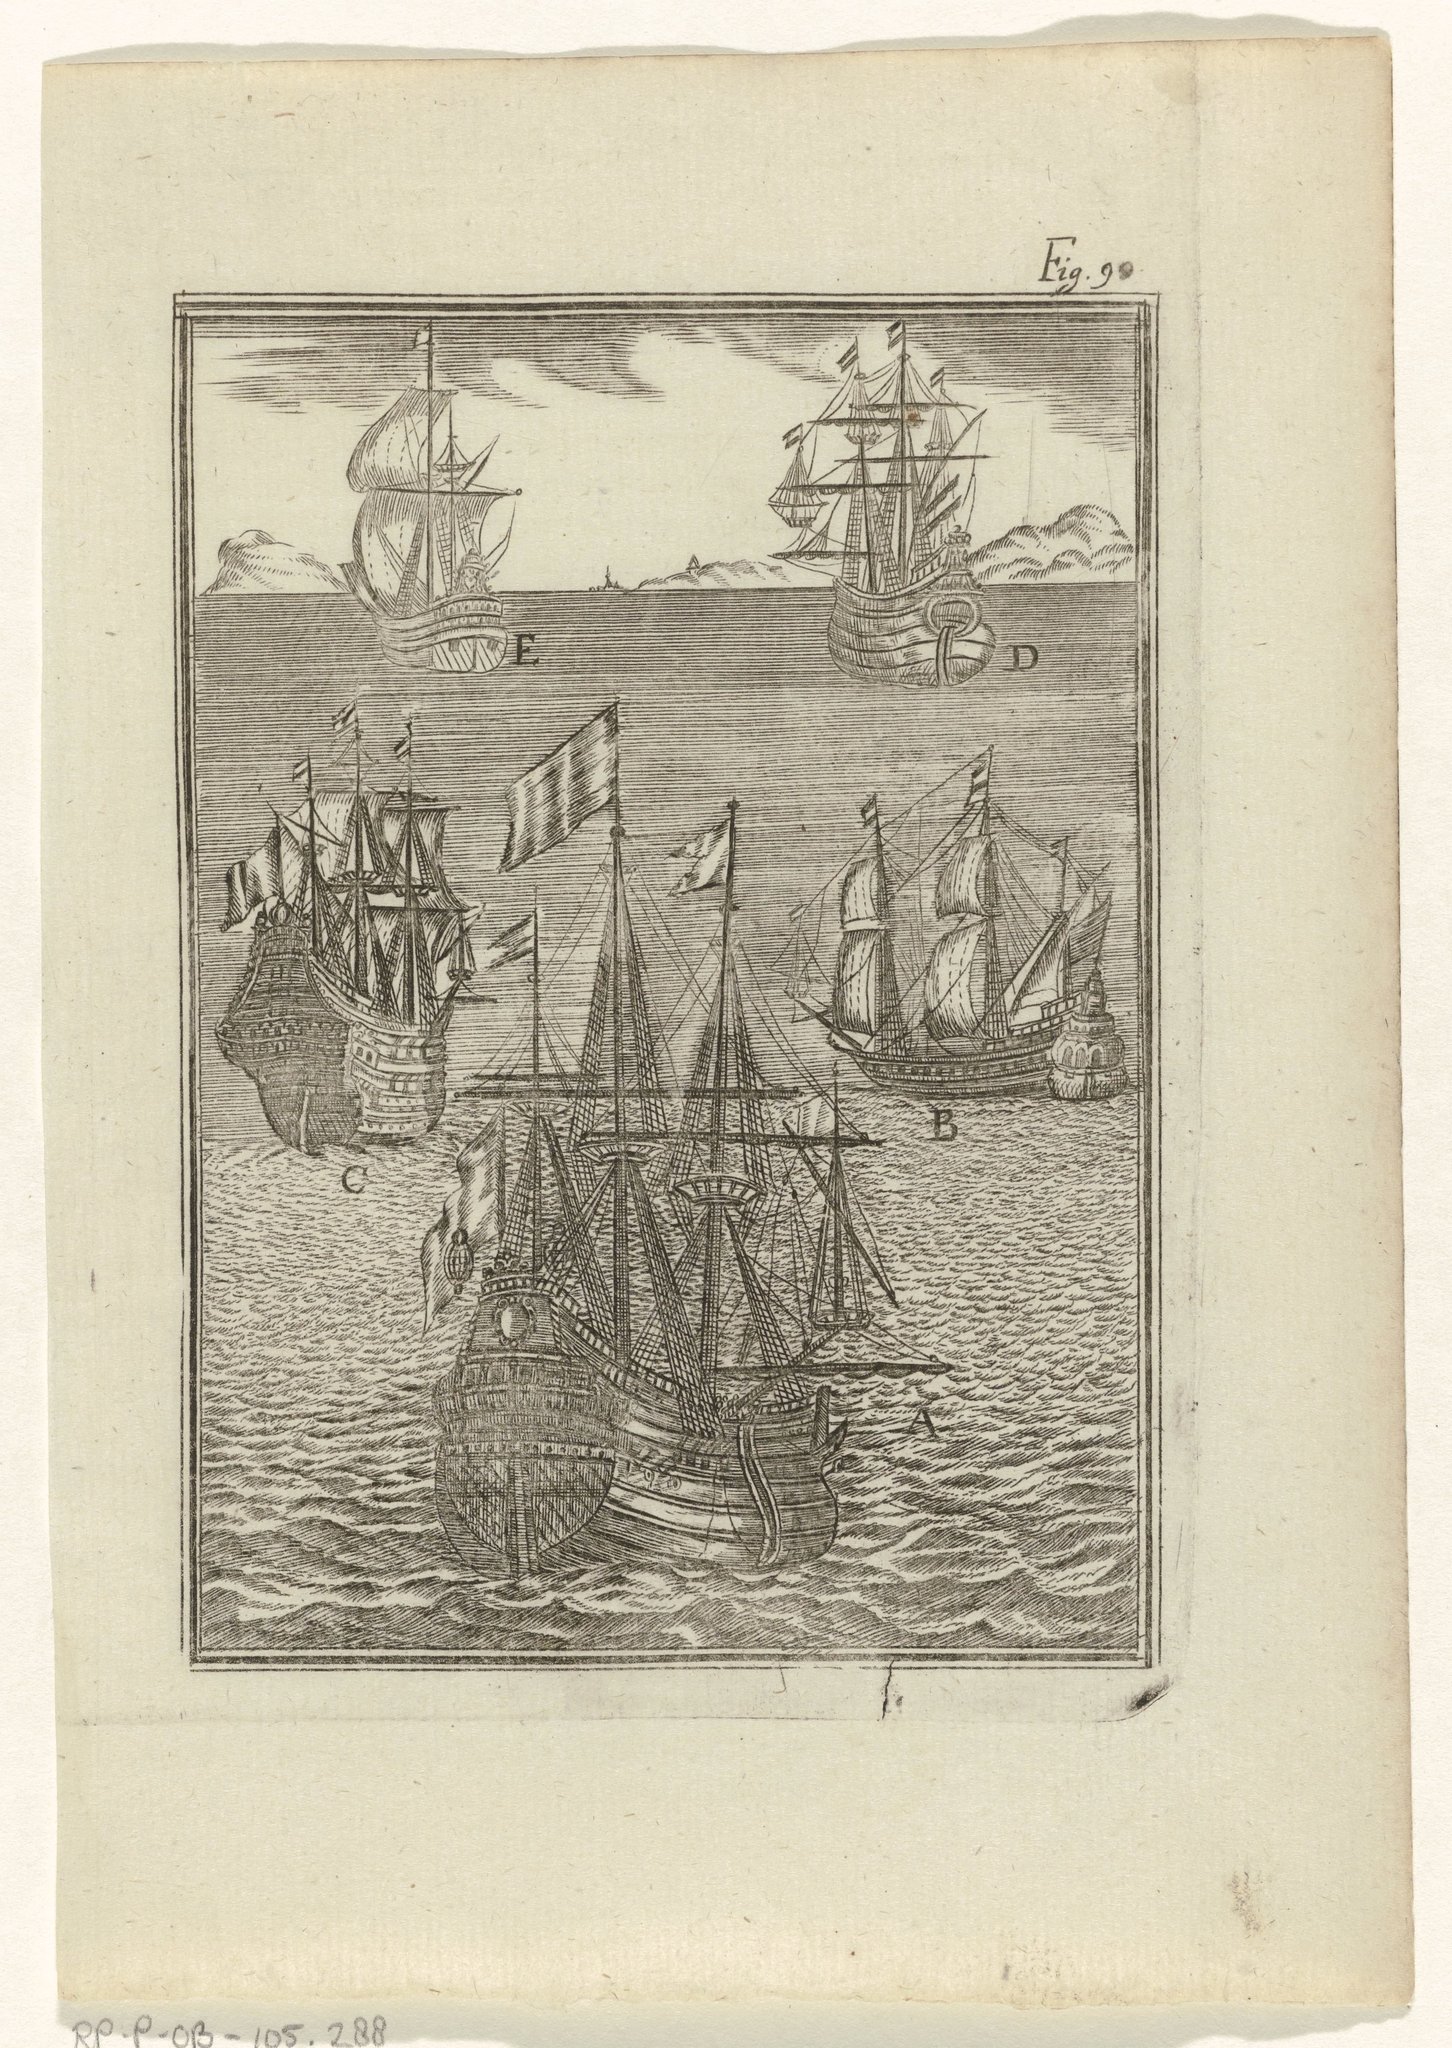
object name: book illustration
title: Vijf zeilschepen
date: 1719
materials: paper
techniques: etching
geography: frankfurt am main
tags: sailing-ship, sailing-boat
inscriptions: collector's mark: Lugt 2228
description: Boekillustratie uit: Mallet, Allain Manesson. Allain Manesson Mallets Beschreibung des gantzen Welt-Kreises. [Vertaald uit het Frans.] Frankkfurt am Main: Johann Adam Jung, 1719. De boekillustraties in deze uitgave zijn gekopieerd naar de boekillustraties in de originele Franse uitgave: Mallet, Allain Manesson. Description de l'univers. Parijs: Denis Thierry, 1683.